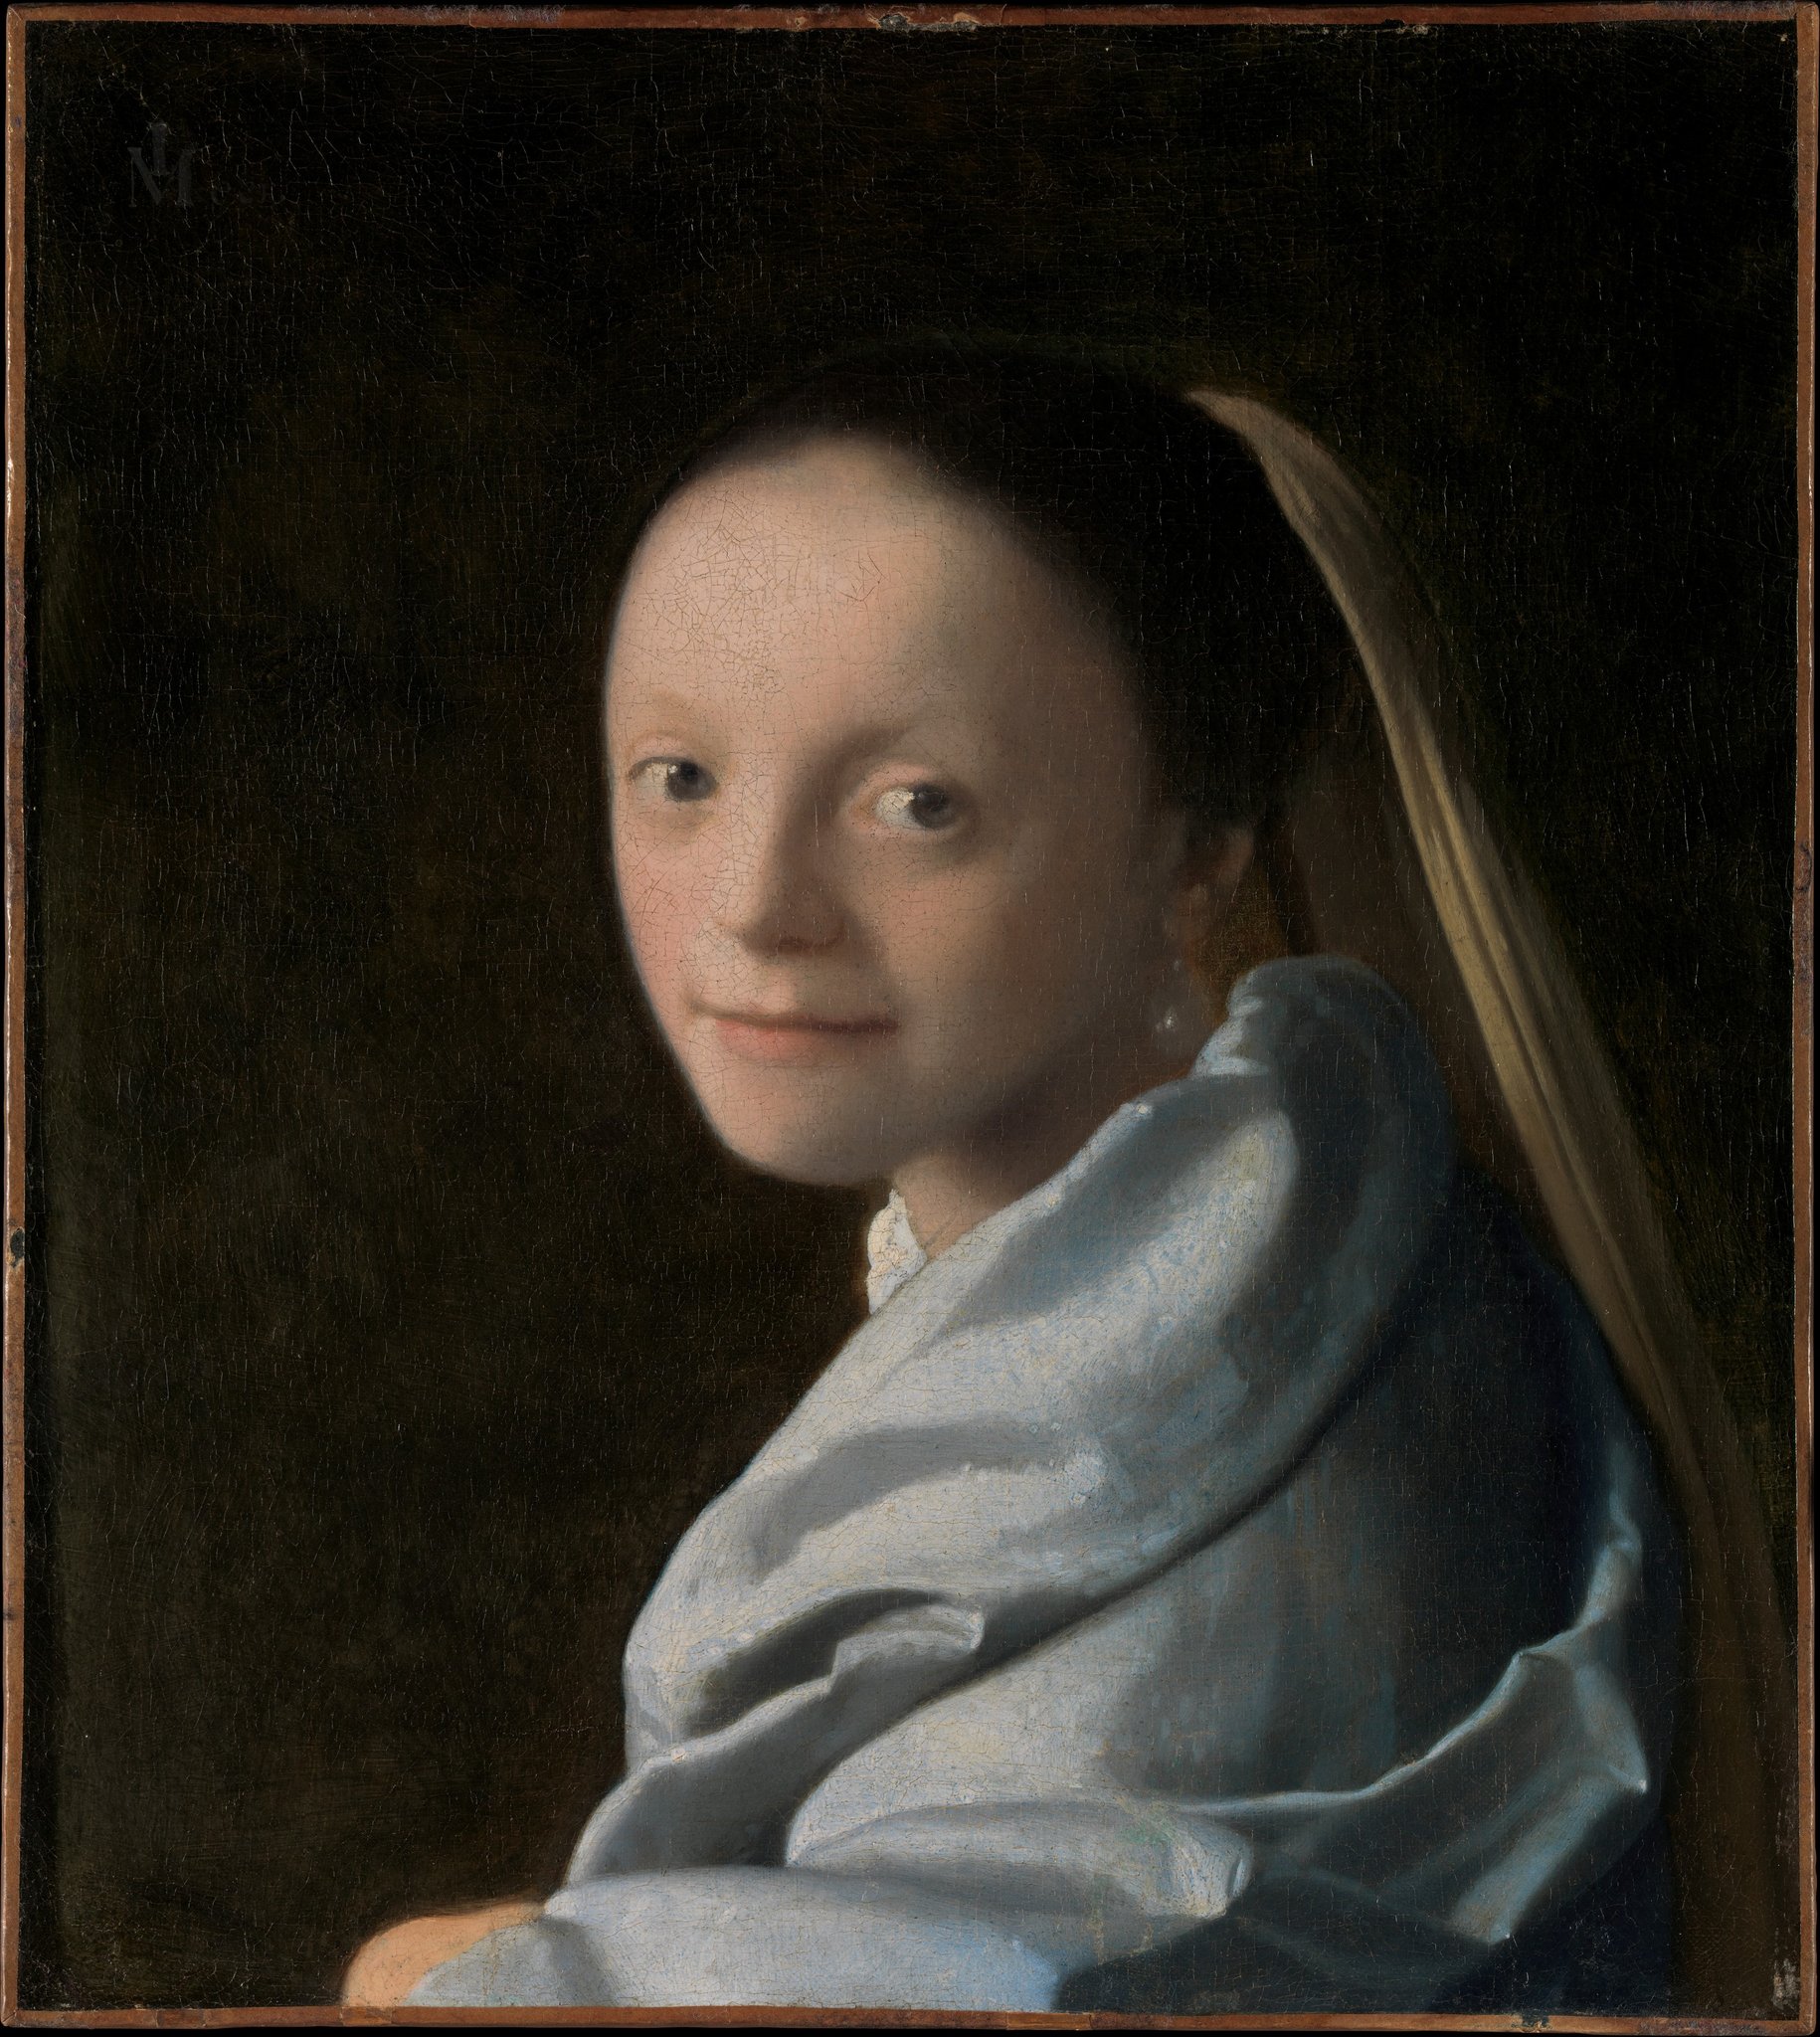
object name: painting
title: Study of a Young Woman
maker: johannes vermeer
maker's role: artist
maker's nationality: dutch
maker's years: 1632-1675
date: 1665-1667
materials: canvas, oil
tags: portraits,women